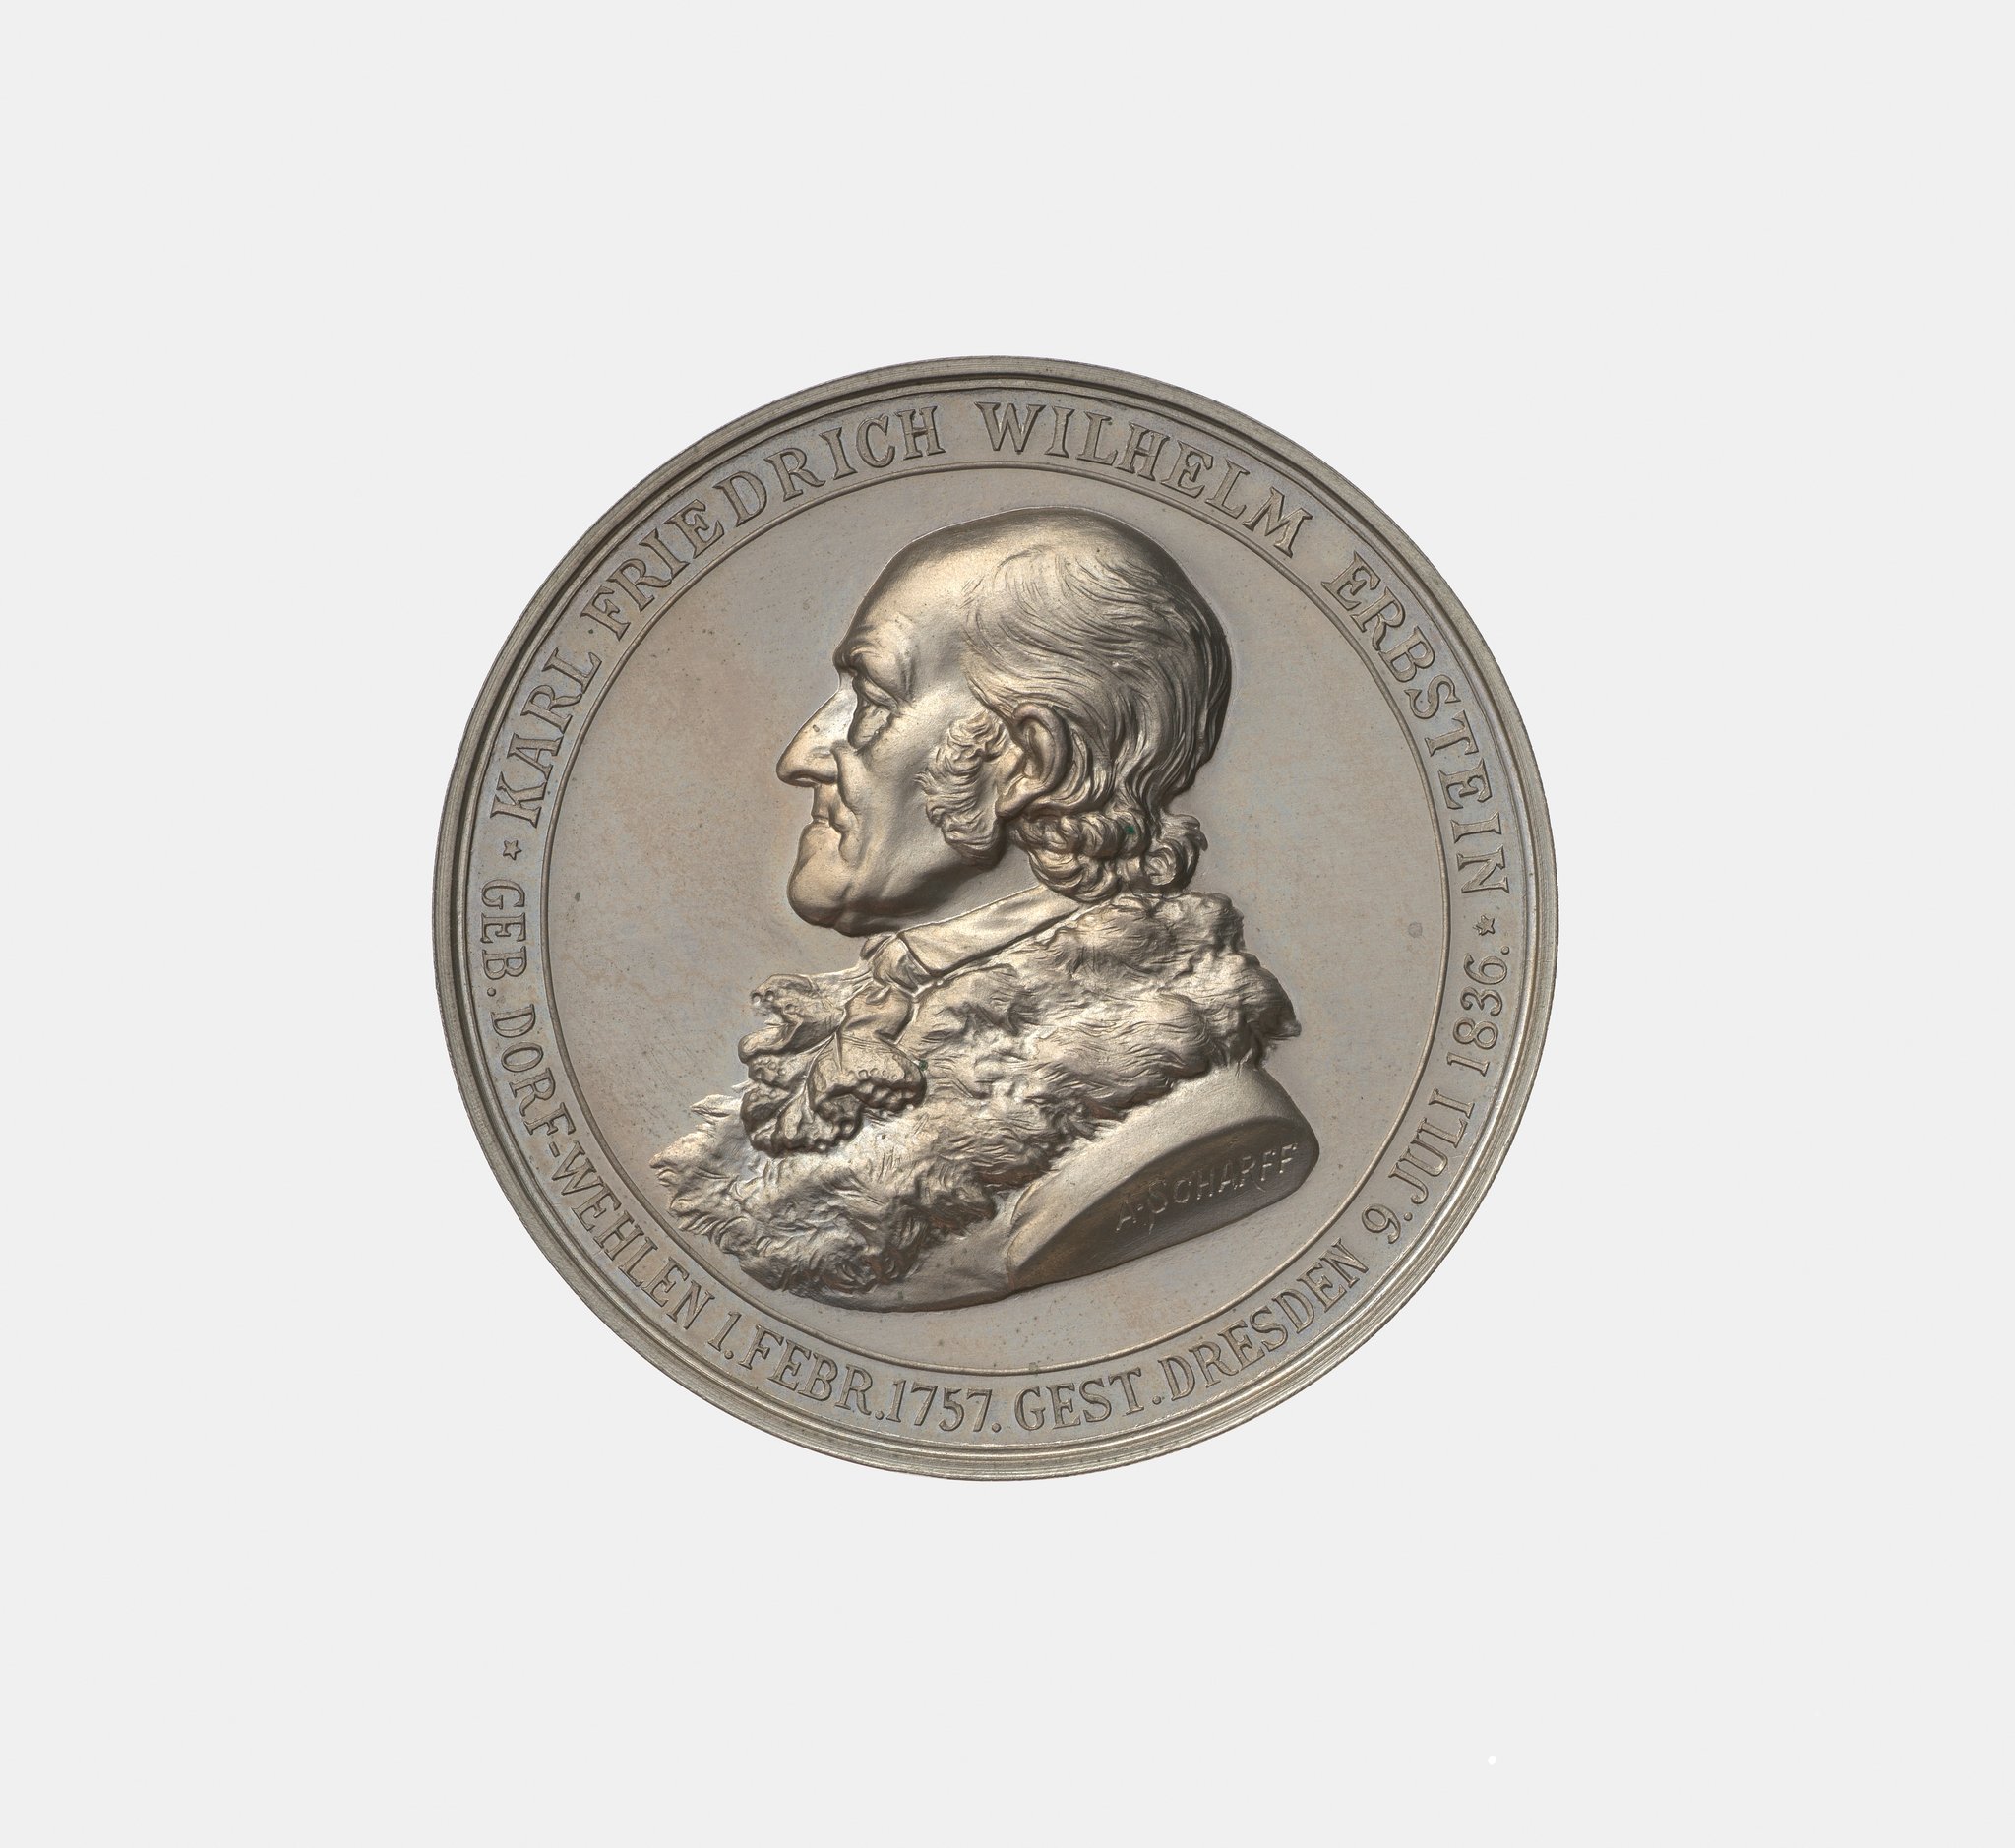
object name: medal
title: Karl Friedrich Wilhelm Erbstein (1757–1836)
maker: anton scharff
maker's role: artist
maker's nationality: austrian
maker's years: 1845-1903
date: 1883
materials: nickel